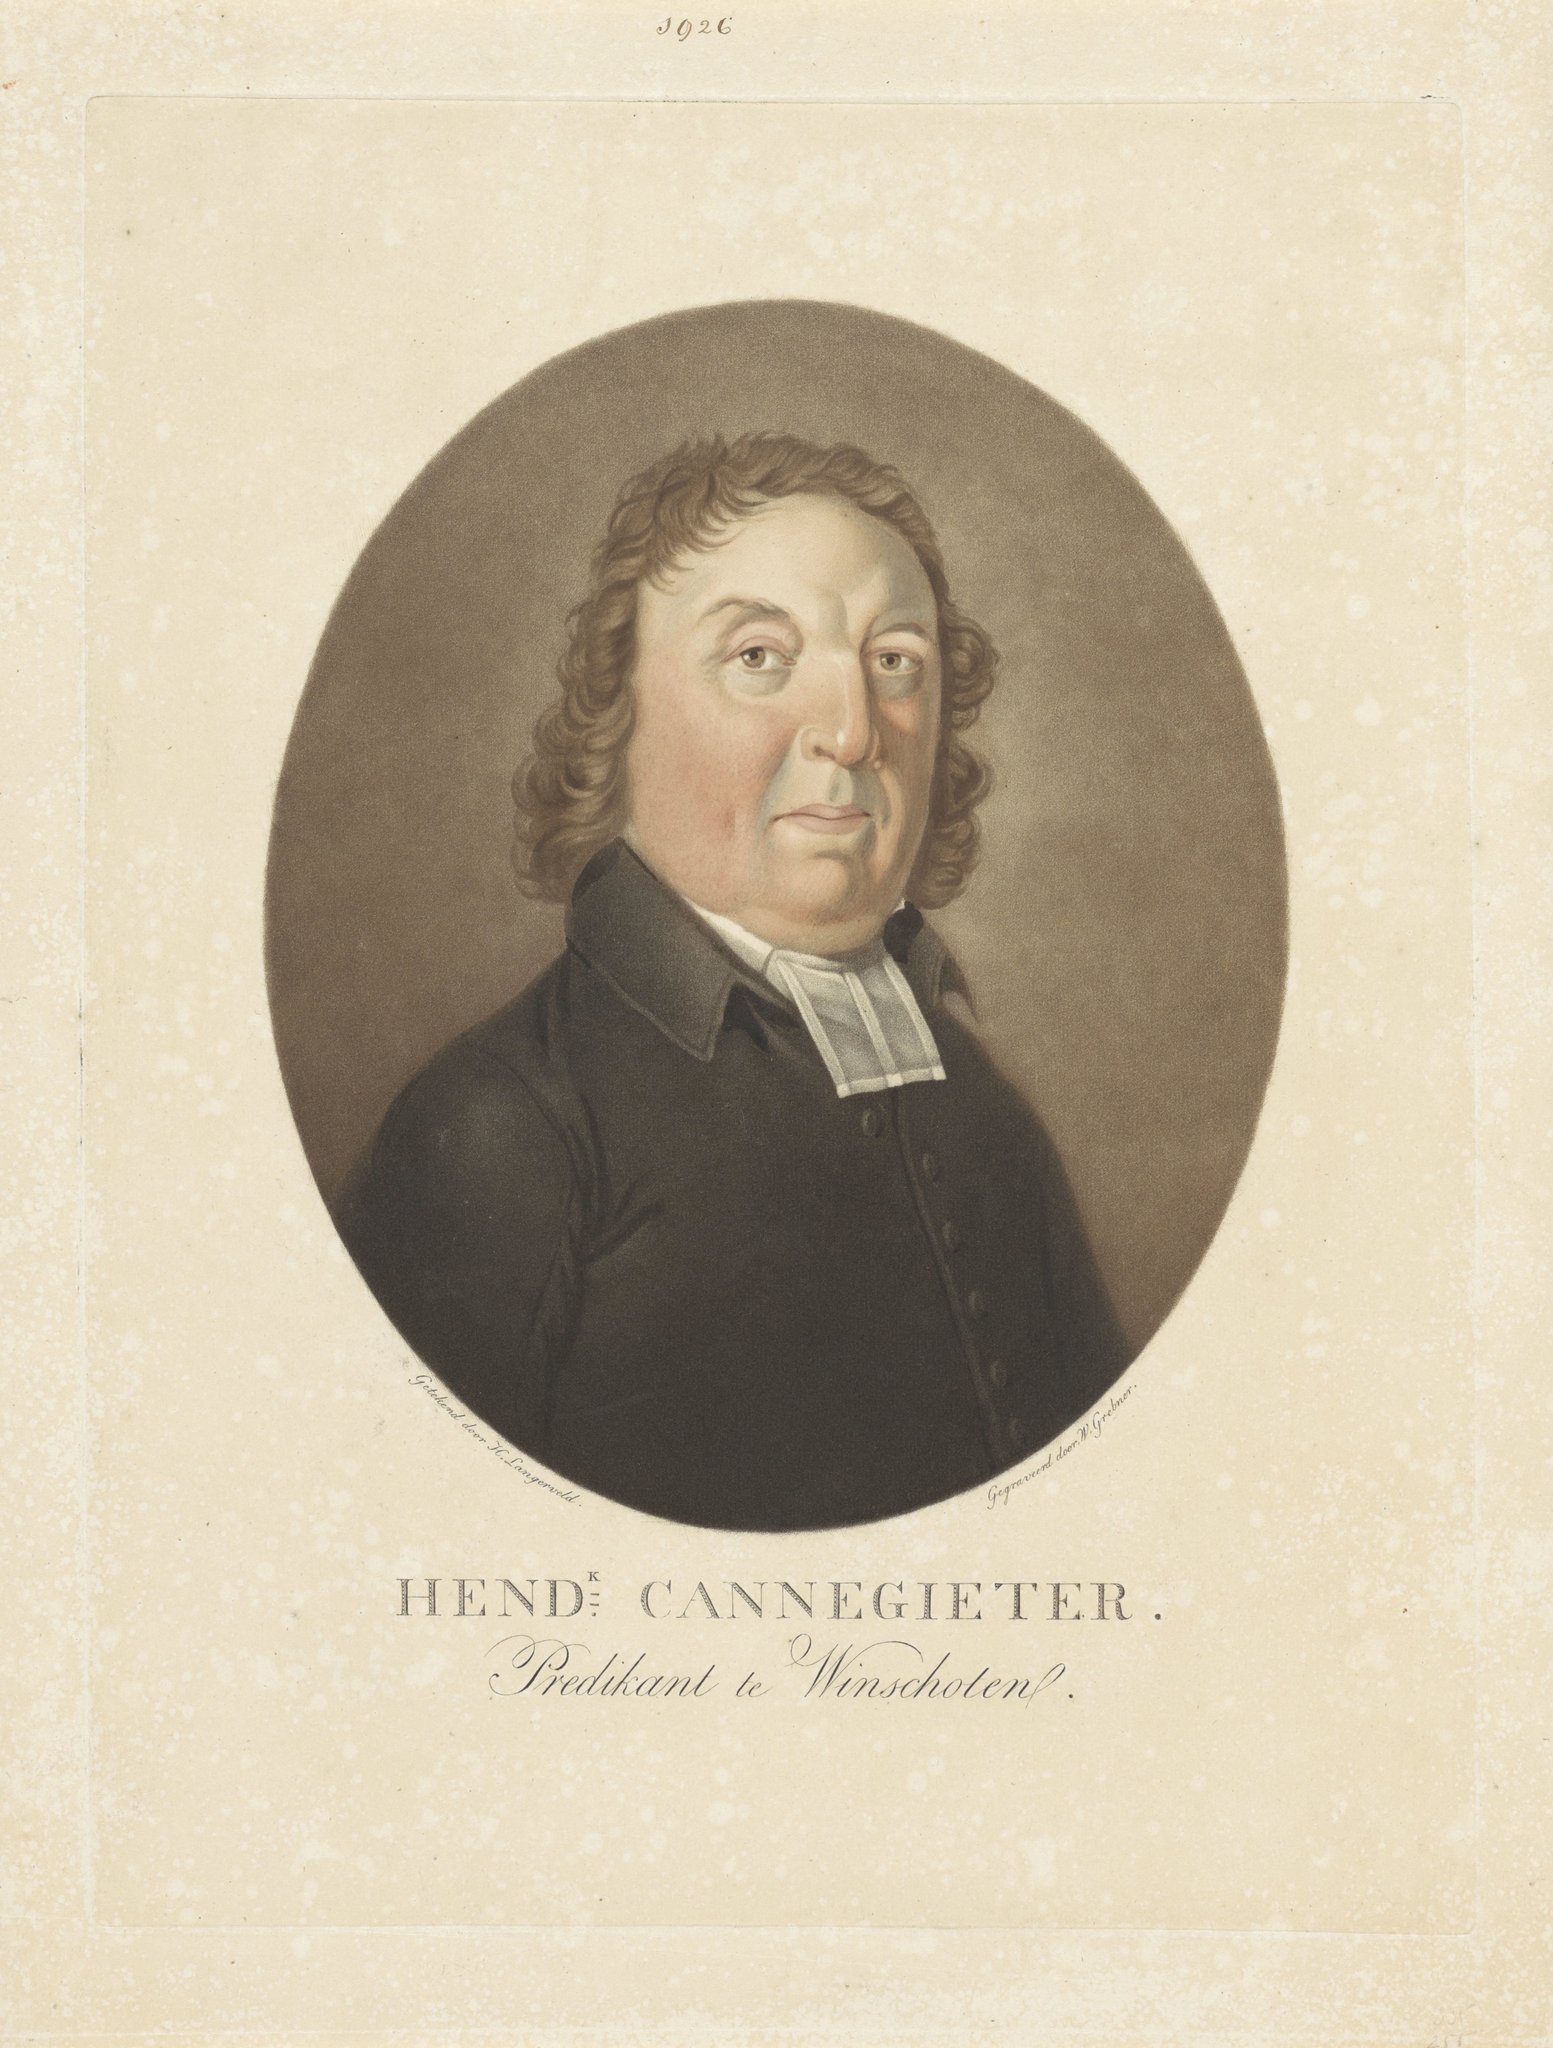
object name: print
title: Portret van de predikant Hendrik Cannegieter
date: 1794-1866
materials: paper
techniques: engraving, hand coloring, lithography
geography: amsterdam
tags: hendrik cannegieter (predikant)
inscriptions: collector's mark: Lugt 2228